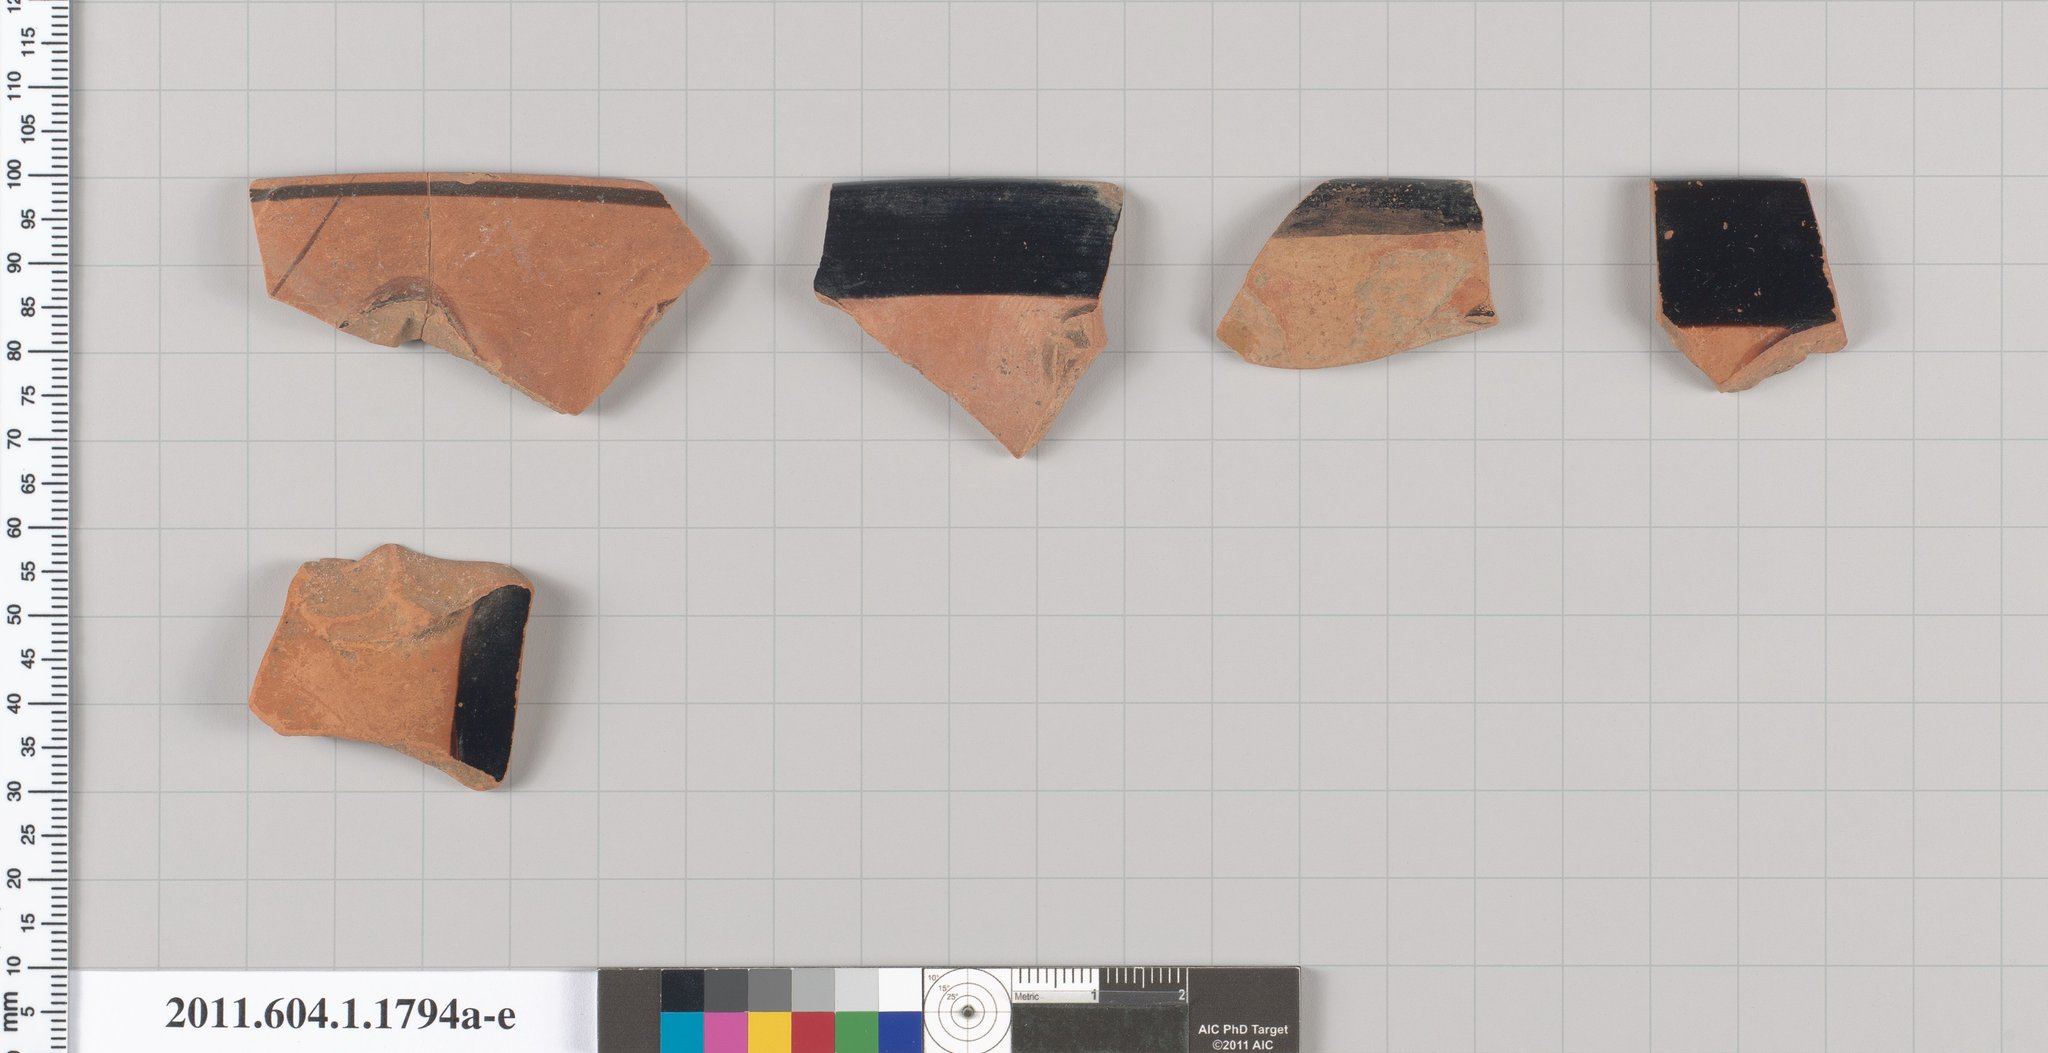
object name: kylix fragment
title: Terracotta rim fragments of kylikes(drinking cups)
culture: greek, attic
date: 500-401 BCE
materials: terracotta